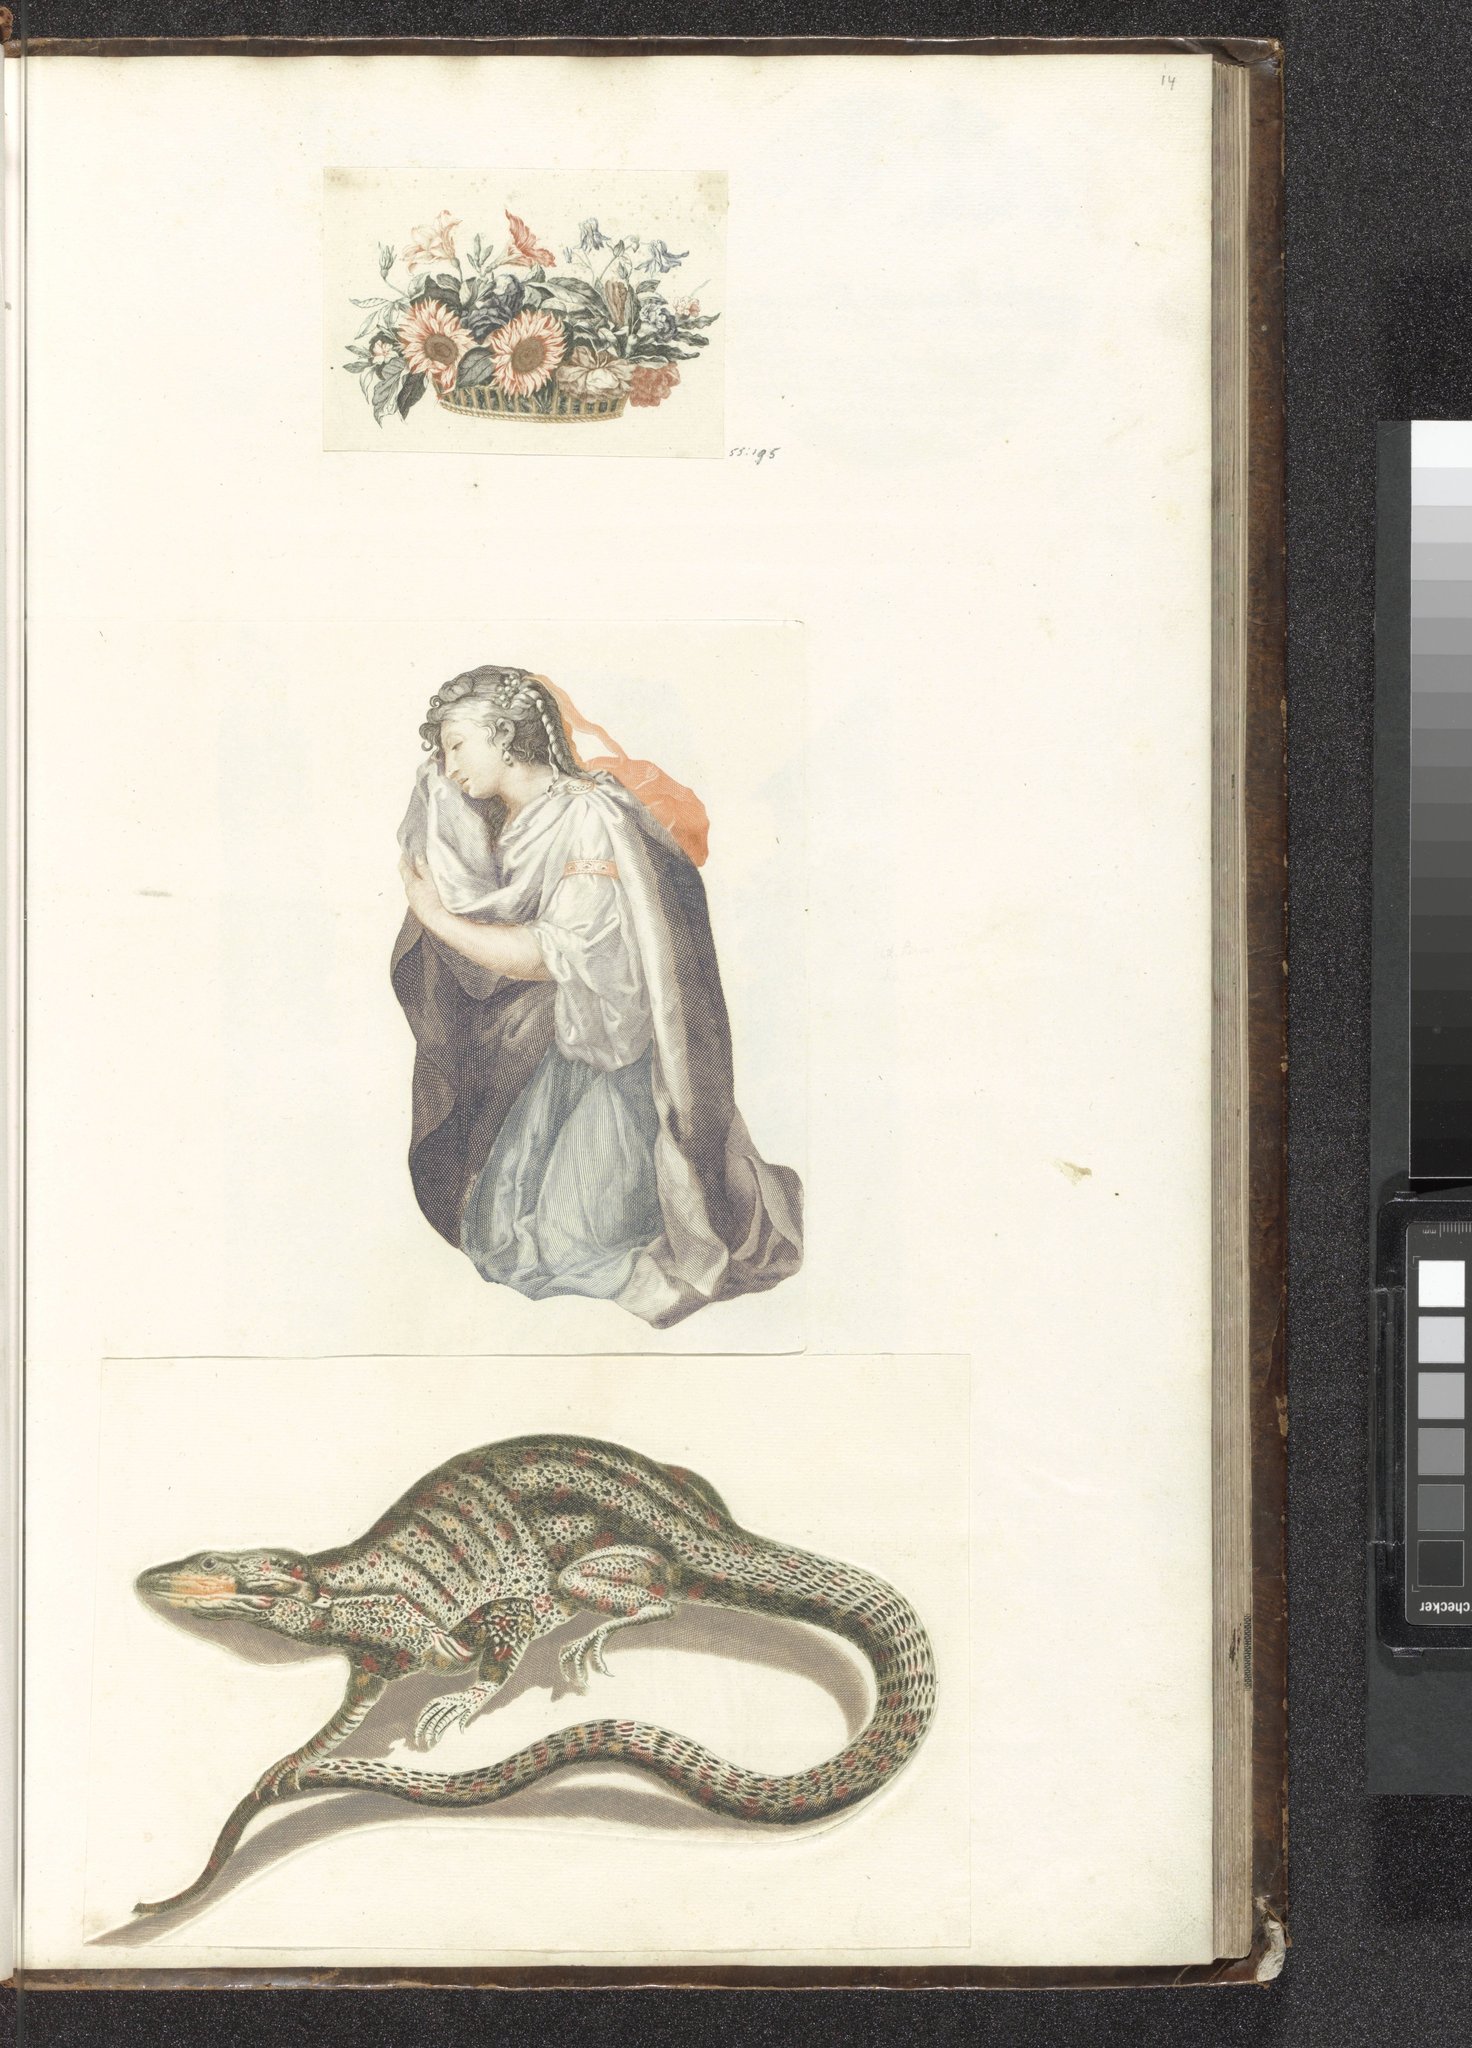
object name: print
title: Treurende geknielde vrouw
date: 1688-1698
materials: paper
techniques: printing, engraving, lithography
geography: netherlands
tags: kneeling figure - aa - female human figure, weeping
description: Deze prent maakt deel uit van een album.